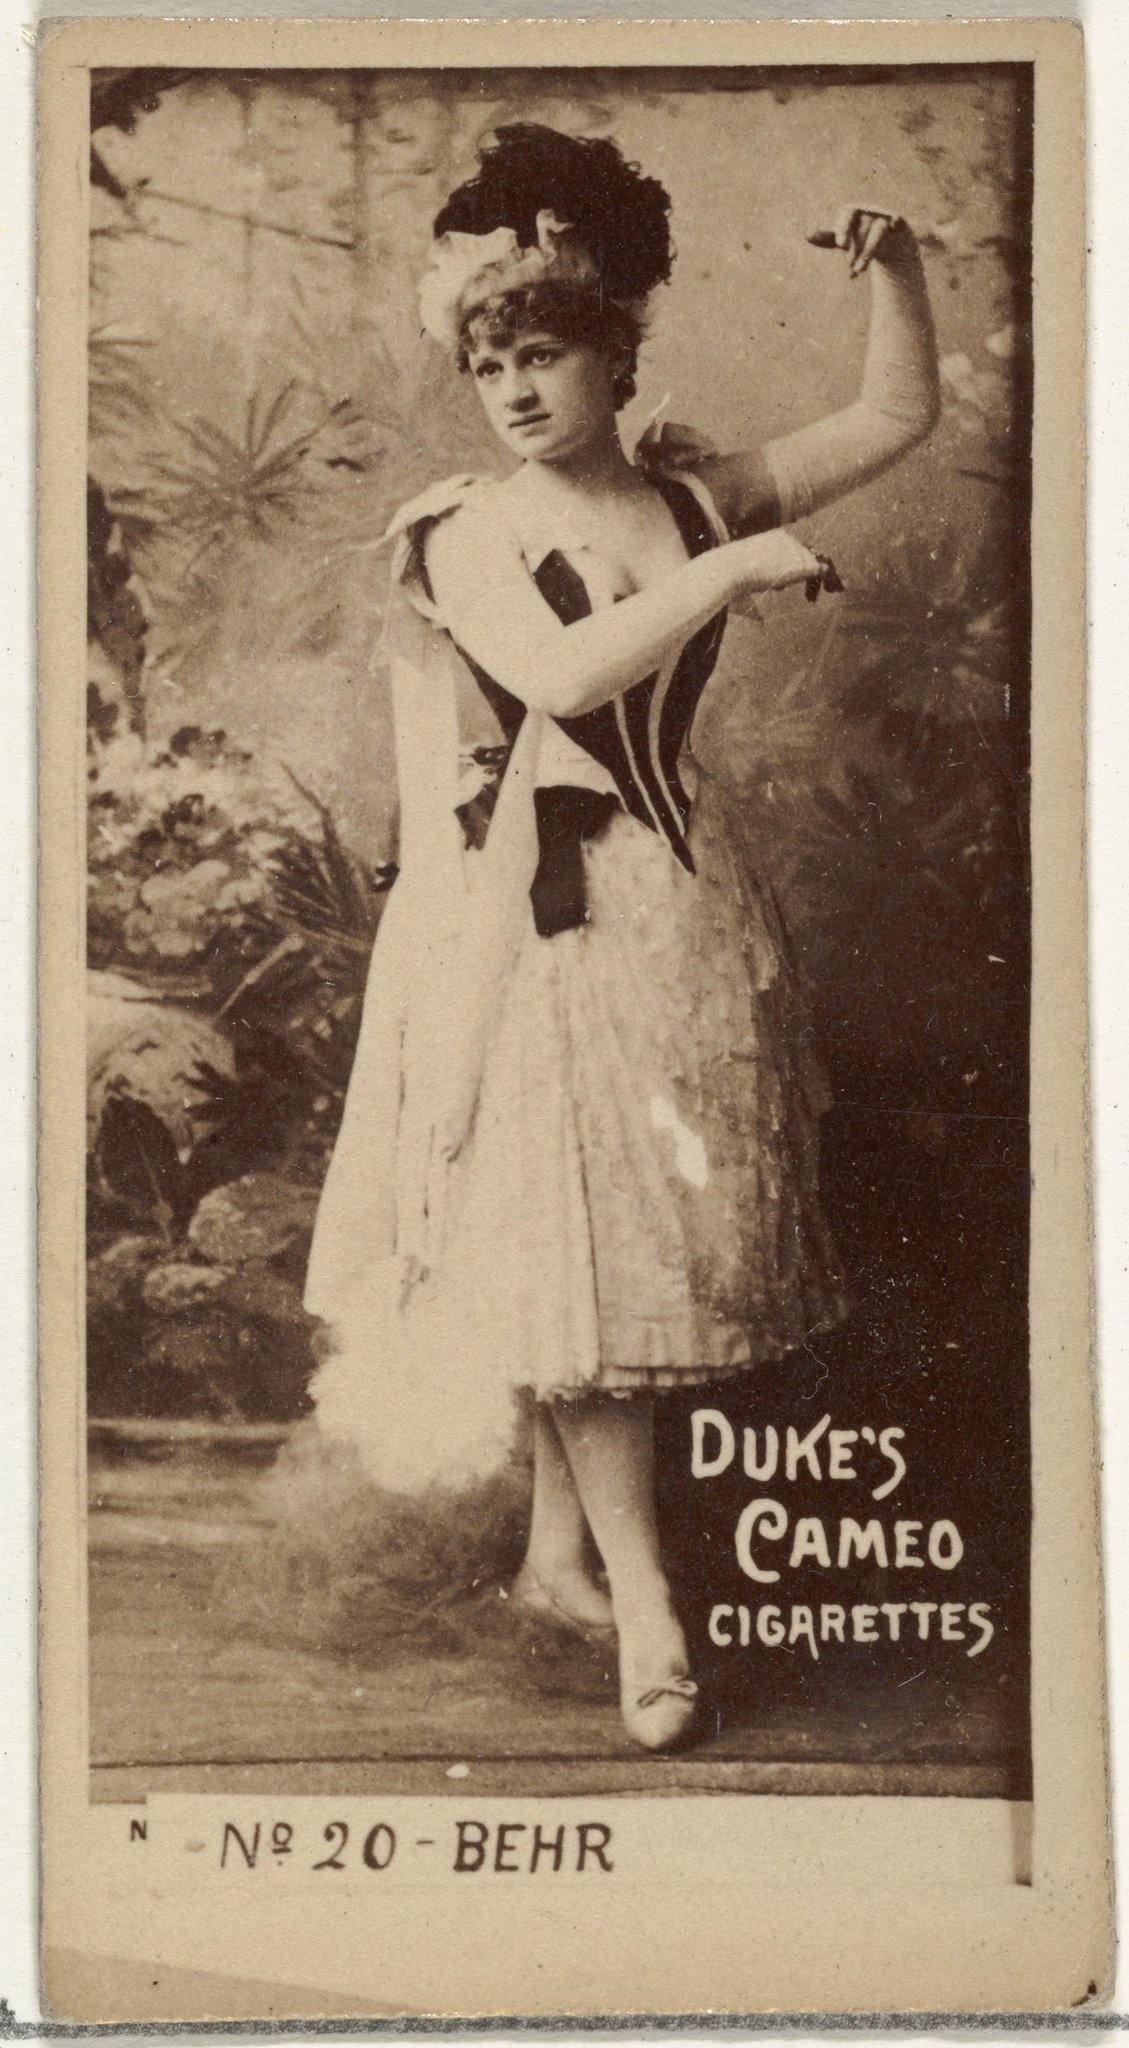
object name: photograph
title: Card Number 20, Behr, from the Actors and Actresses series (N145-4) issued by Duke Sons & Co. to promote Cameo Cigarettes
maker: w. duke, sons & co.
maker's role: publisher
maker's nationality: american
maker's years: 1870-1920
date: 1880-1889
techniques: albumen silver print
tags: portraits,women,actresses